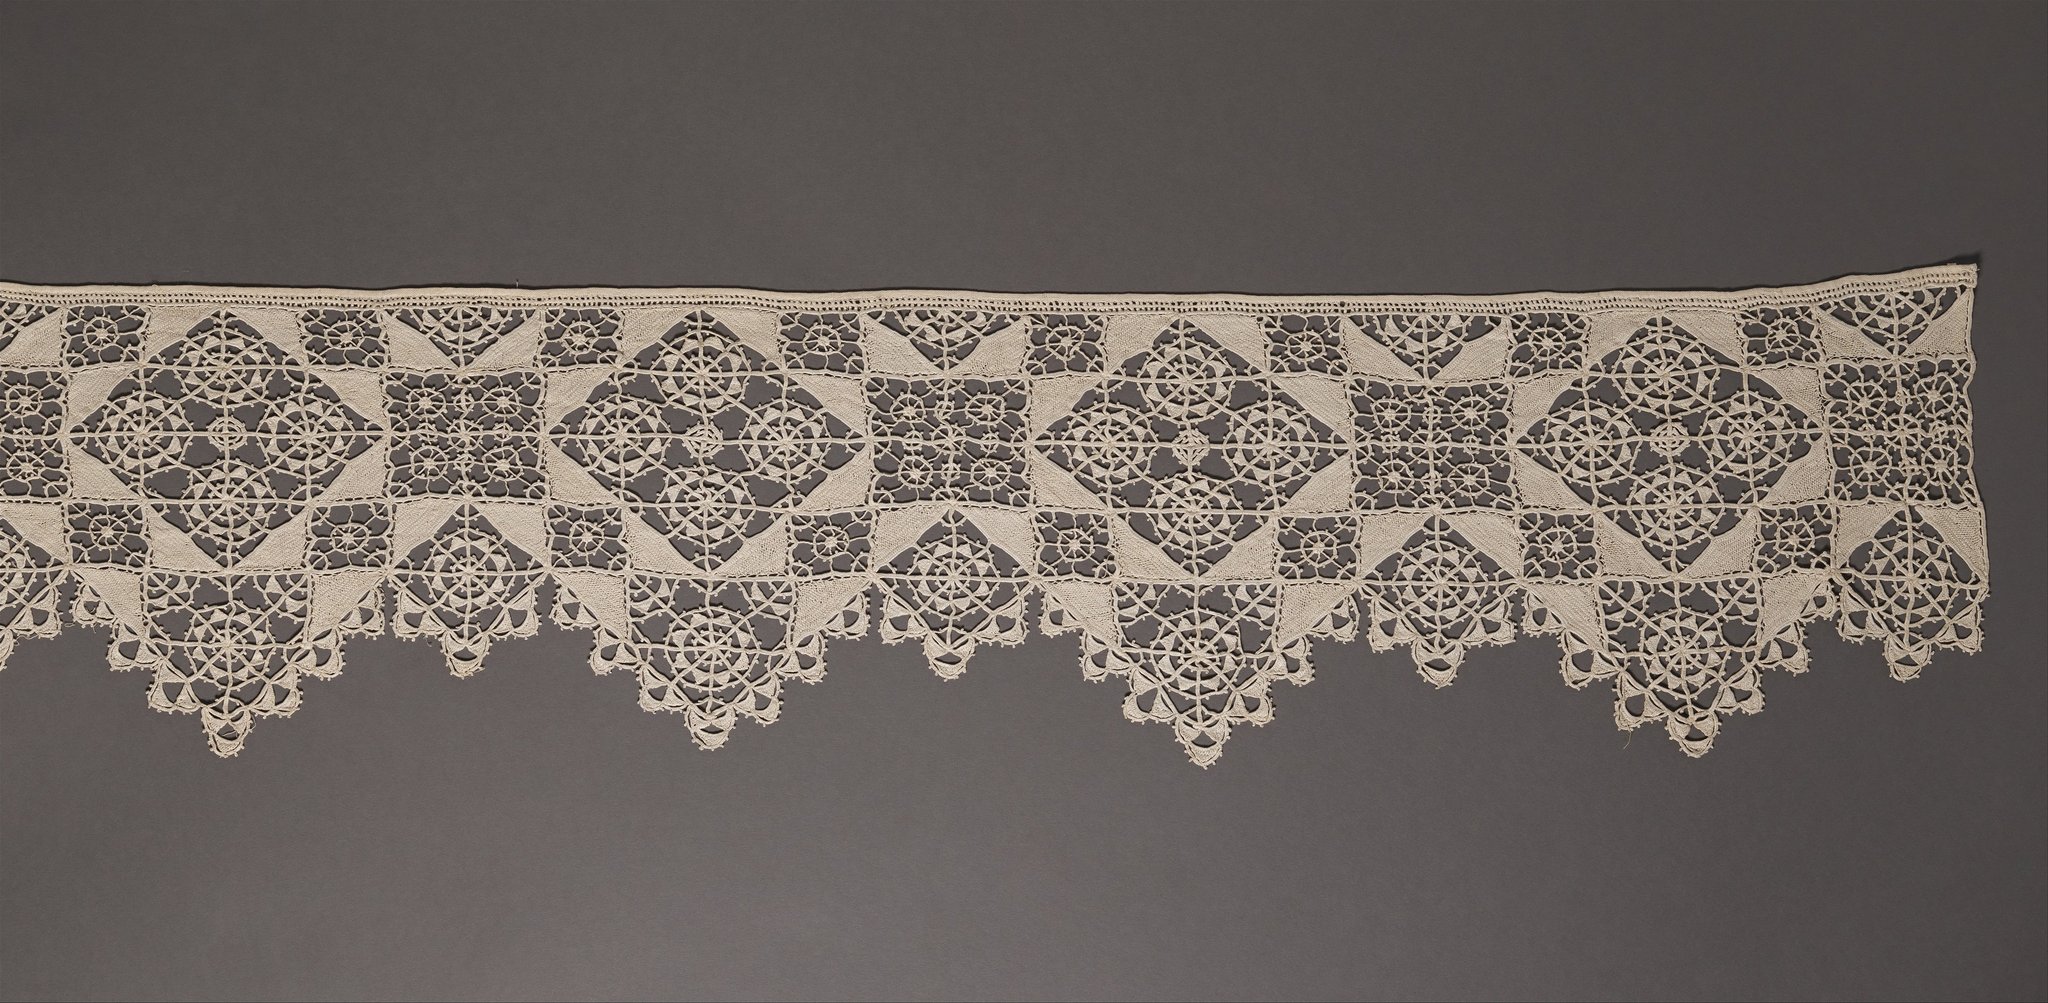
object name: edging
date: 1601-1700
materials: linen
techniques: embroidery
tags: flowers